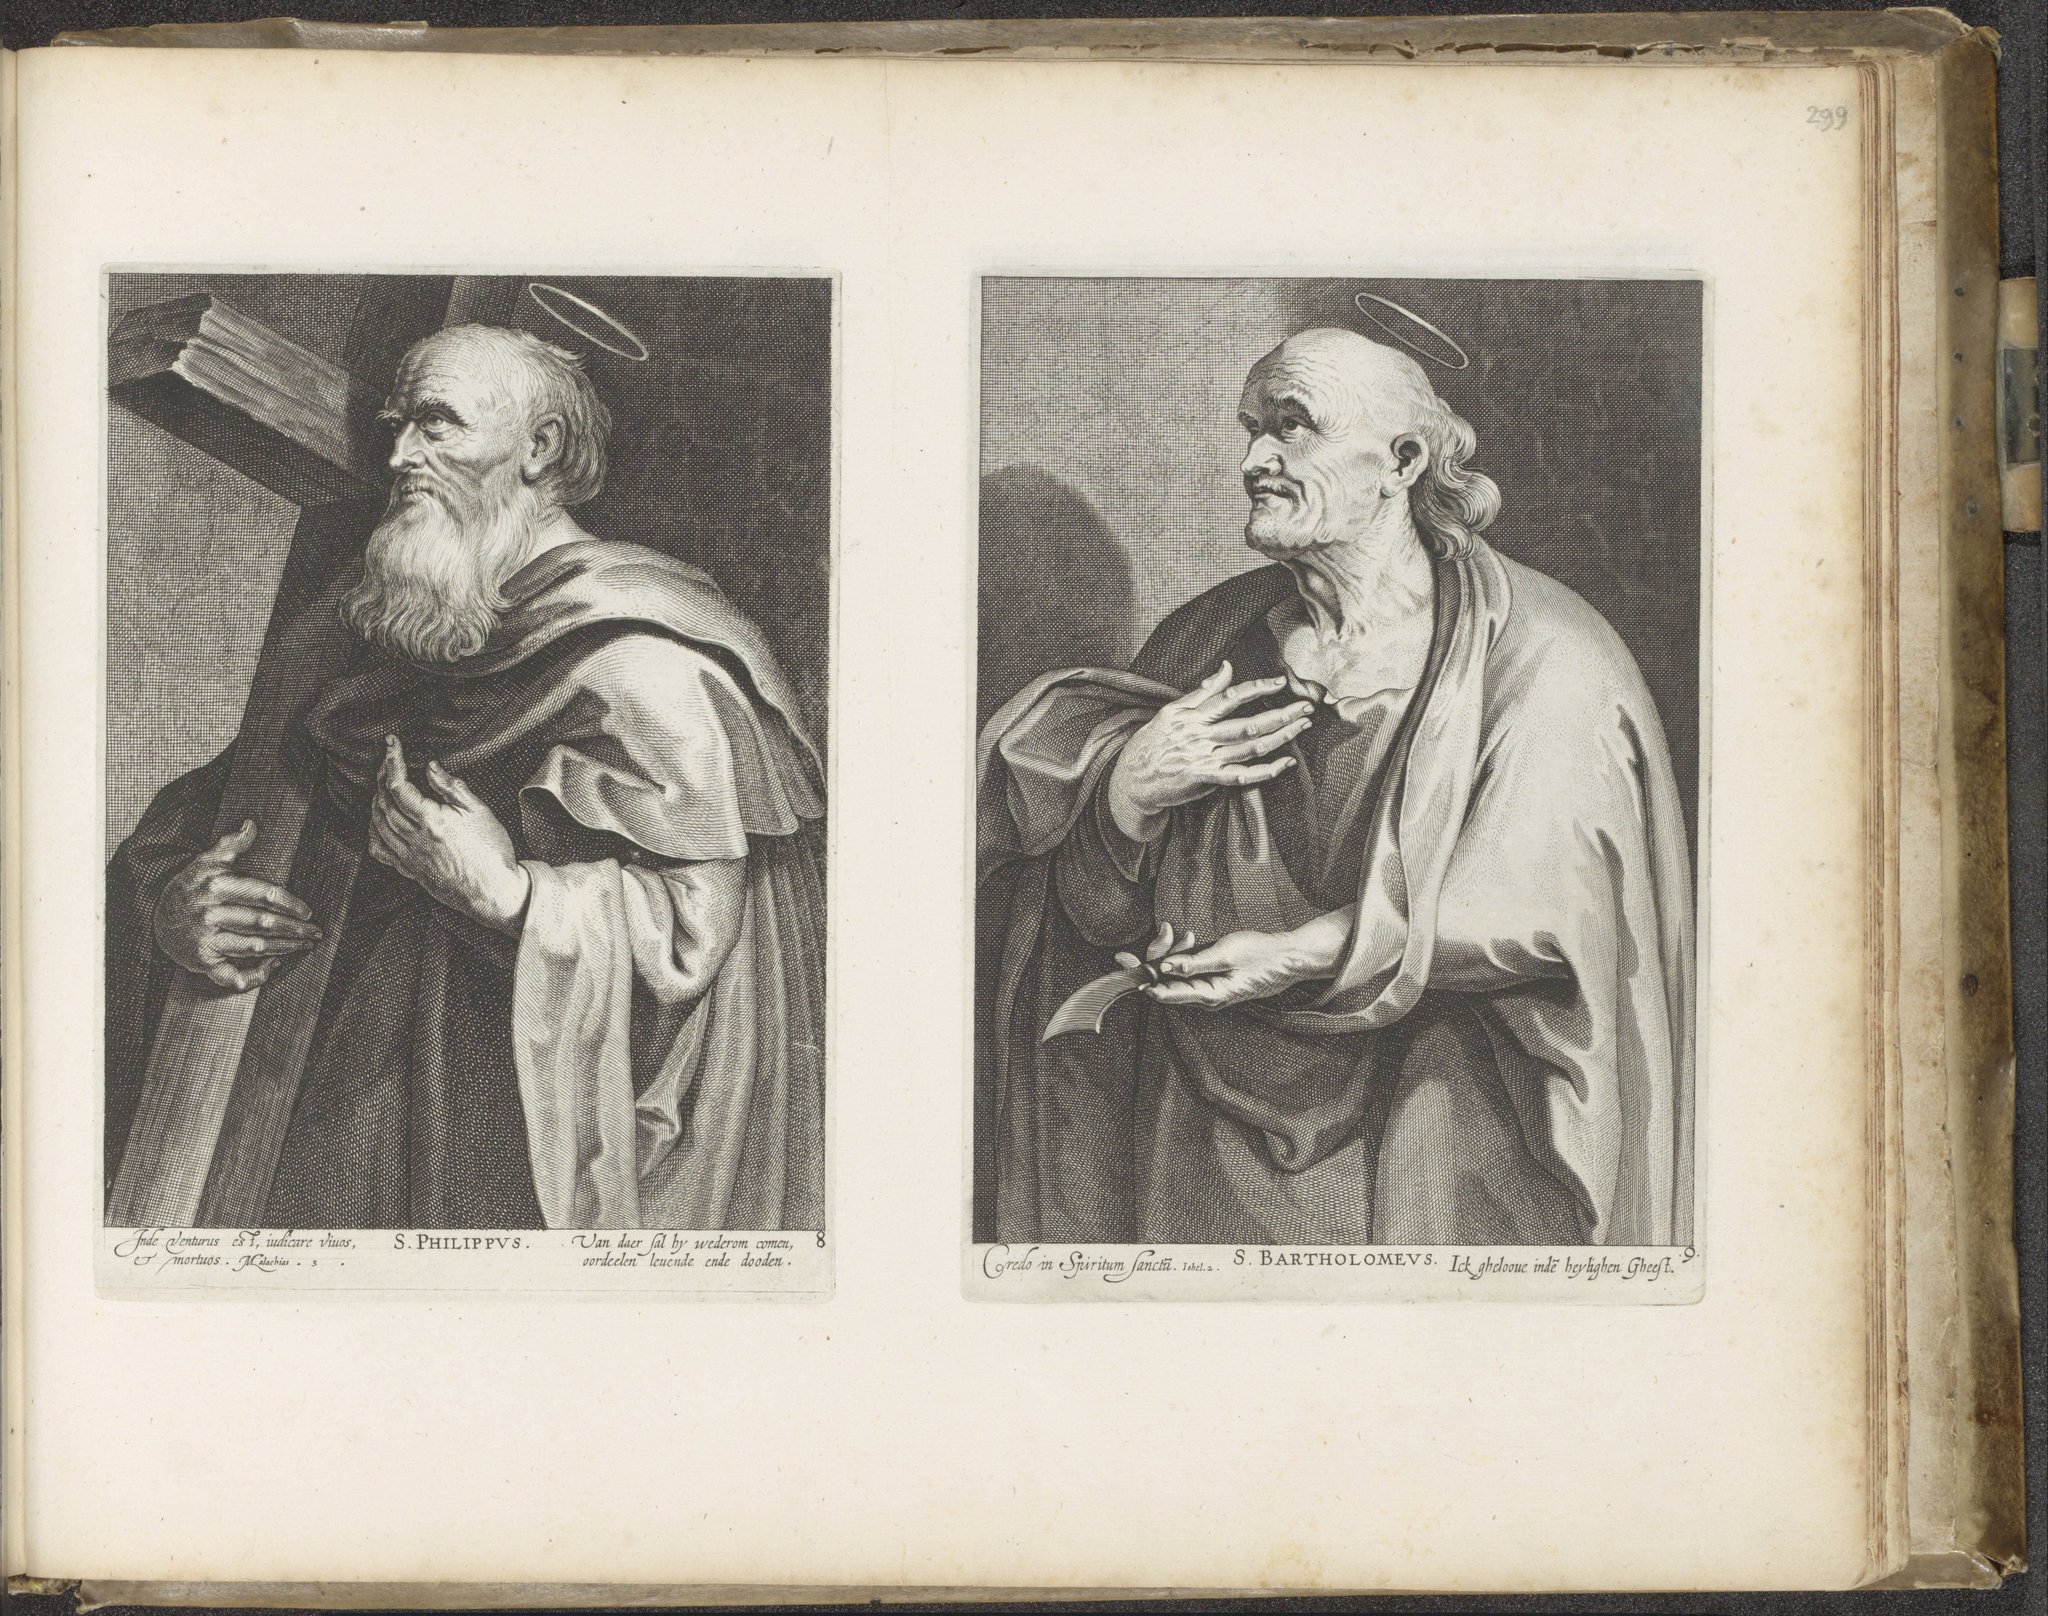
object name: album leaf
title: Den Grooten Emblemata Sacra, bestaande in meer dan vier hondert bybelsche figuren, zoo des Ouden als des Nieuwen Testaments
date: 1616-1626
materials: paper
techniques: engraving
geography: amsterdam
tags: the apostle bartholomew; possible attributes: book, devil or dragon at feet, knife, scroll, flayed skin, staff, the apostle philip; possible attributes: book, cross, dish with snake, lance, scroll, stone, sword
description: Twee voorstellingen op een albumblad. Links de apostel Filippus met kruis. Rechts Bartolomeüs met mes. In beide ondermarges een tweeregelige tekst in het Latijn en Nederlands. De prent maakt deel uit van een album.